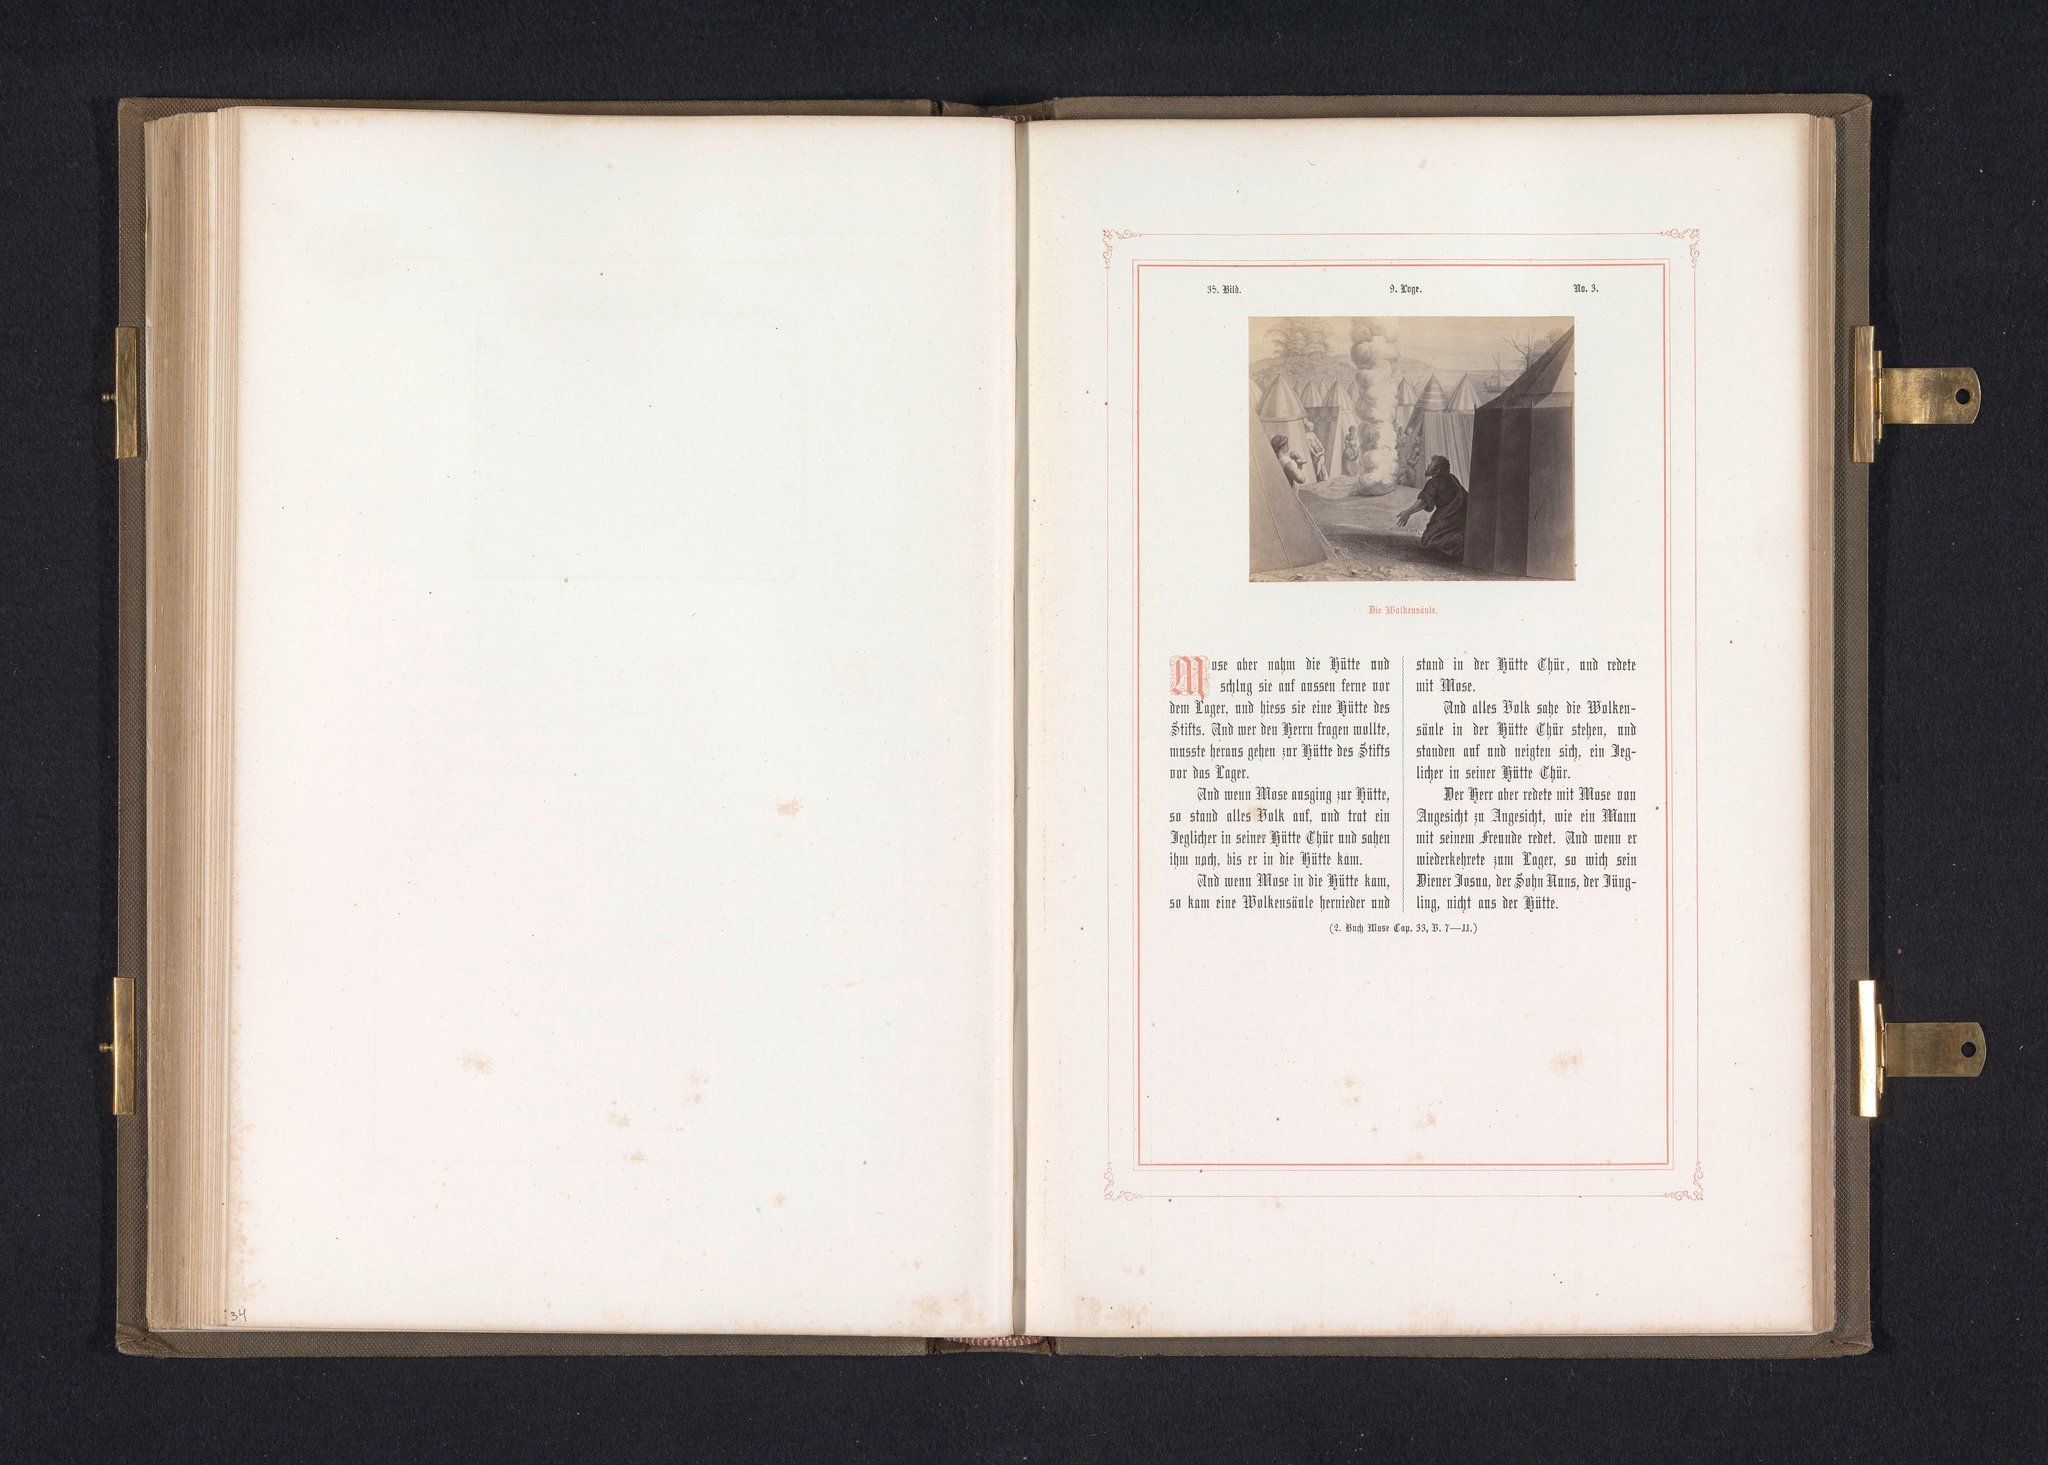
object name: photograph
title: Fotoreproductie van een prent naar een fresco van Moses die knielt voor een verschijning van wolken door Rafaël voor de loggia's in het Vaticaan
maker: gustav schauer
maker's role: painter, publisher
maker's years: 1826-1902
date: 1851-1861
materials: photographic support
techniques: albumen print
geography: berlin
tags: moses communicating with god on mount sinai (the mountain may be covered by a thick cloud)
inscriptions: inscription: ‘35. Bild. 9. Loge. No. 3.’